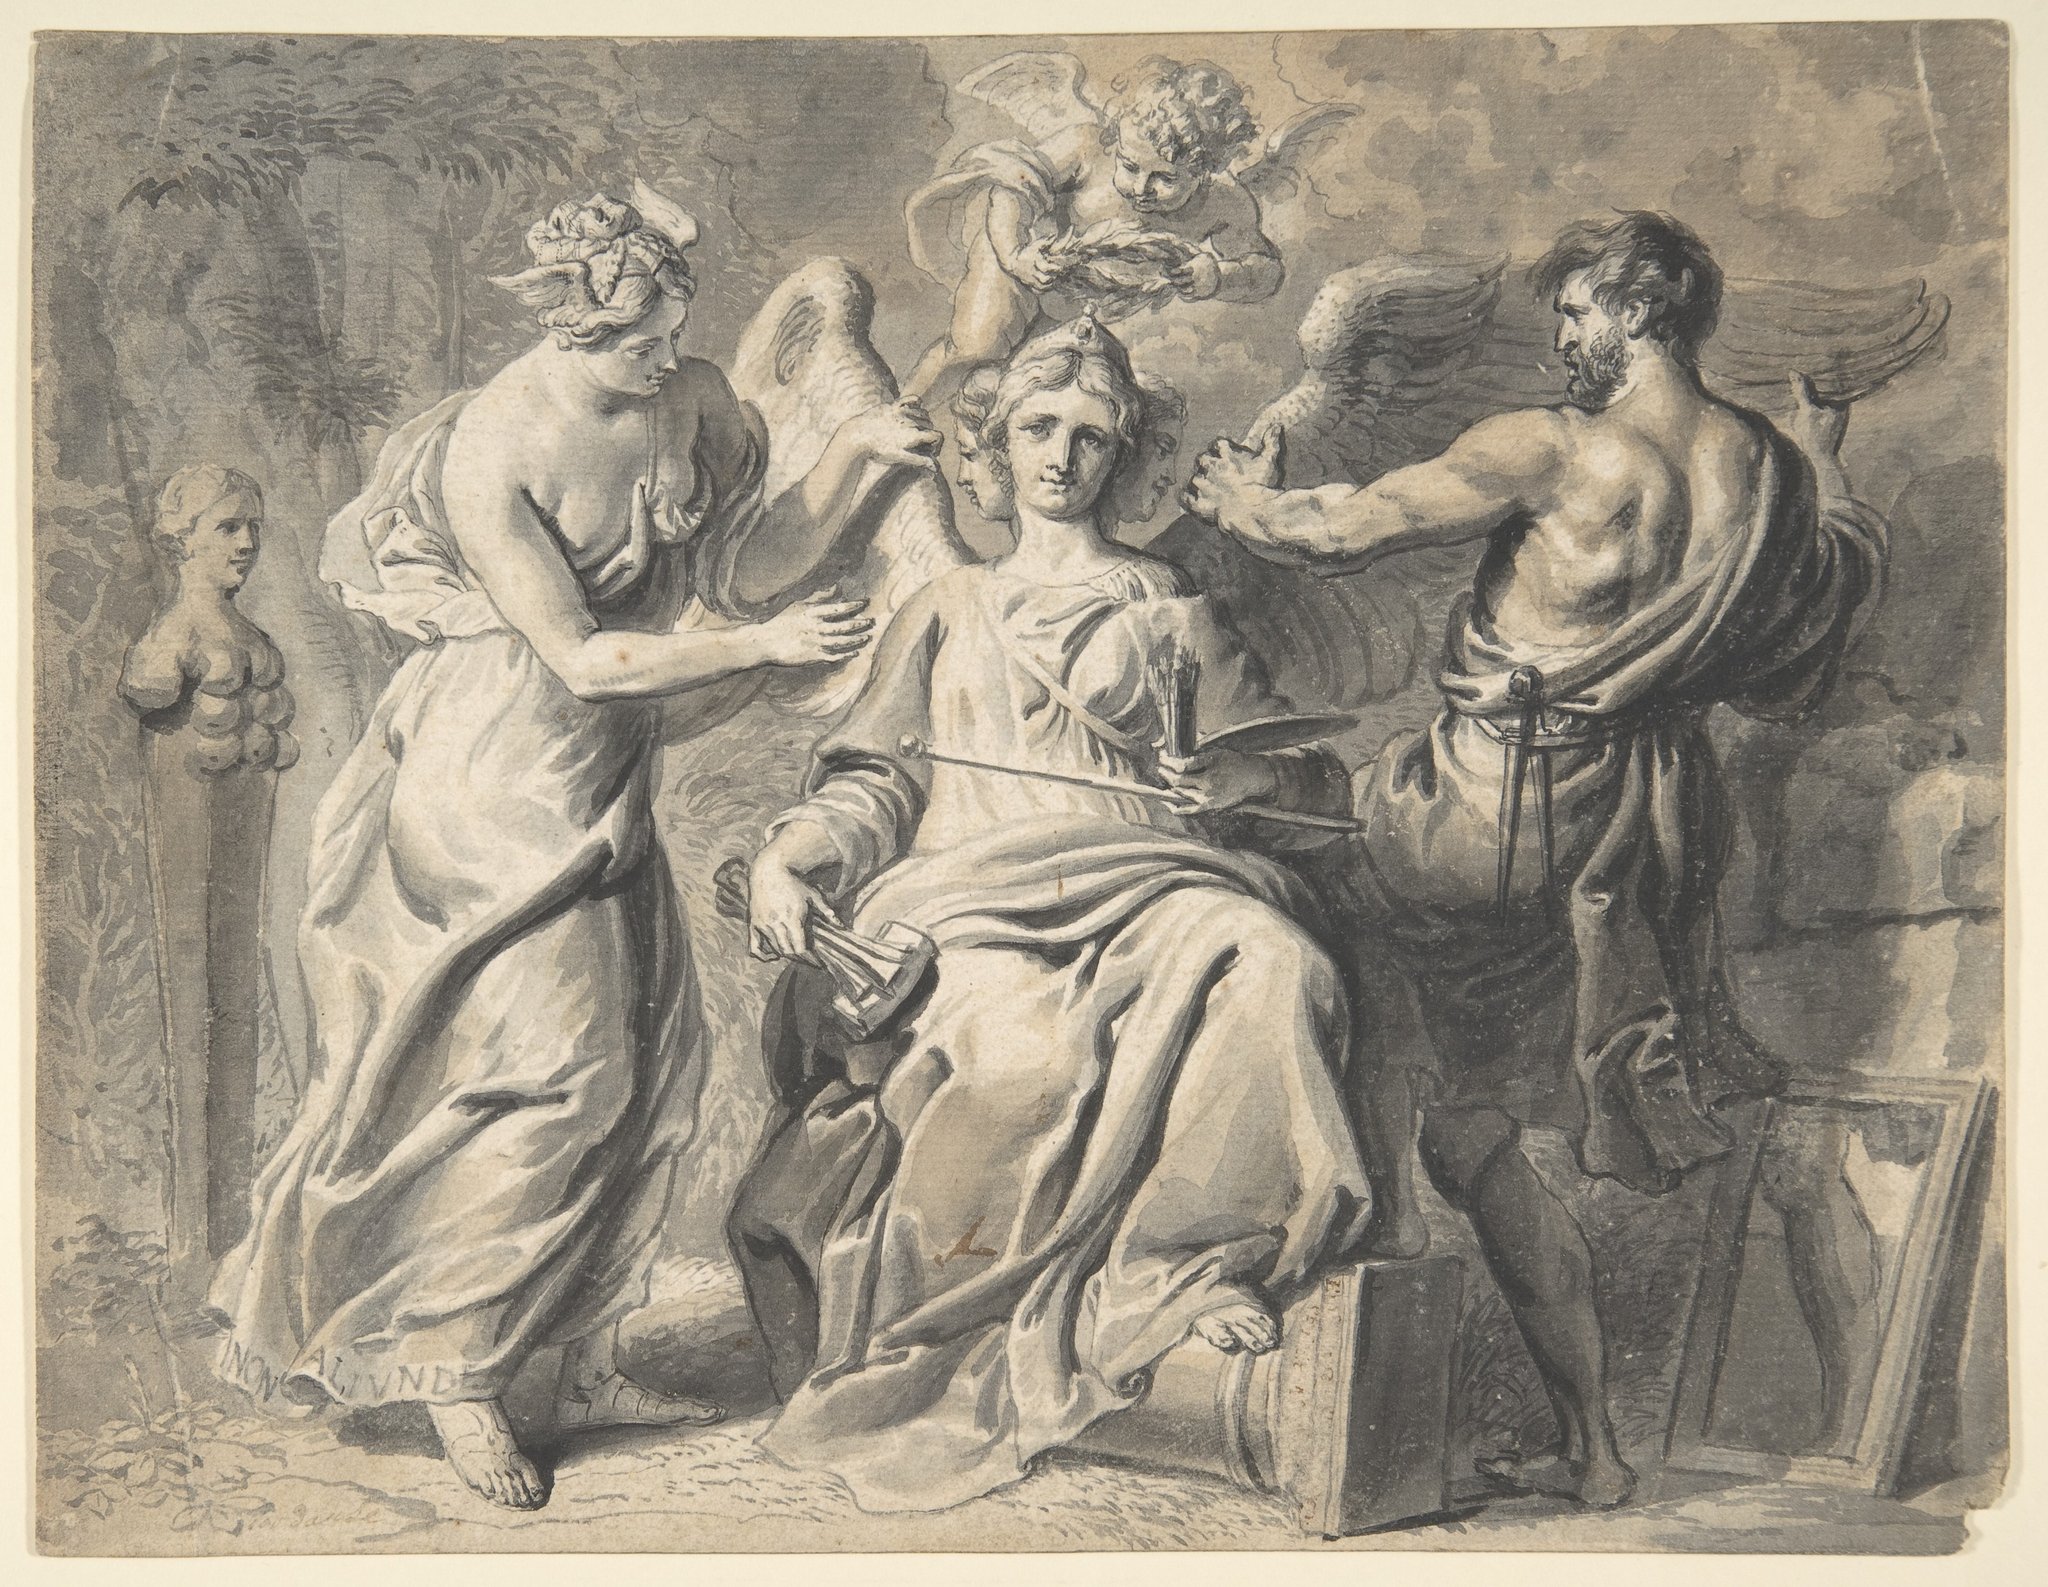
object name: drawing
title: An Allegory of the Arts with Isis and Geometry Attending the Three-headed Figure of Painting and Sculpture, a Putto Crowning her with Laurels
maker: erasmus quellinus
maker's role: artist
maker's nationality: flemish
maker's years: 1607-1678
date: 1601-1700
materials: gouache, ink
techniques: brush, heightening, wash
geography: belgium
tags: men,women,isis,putti